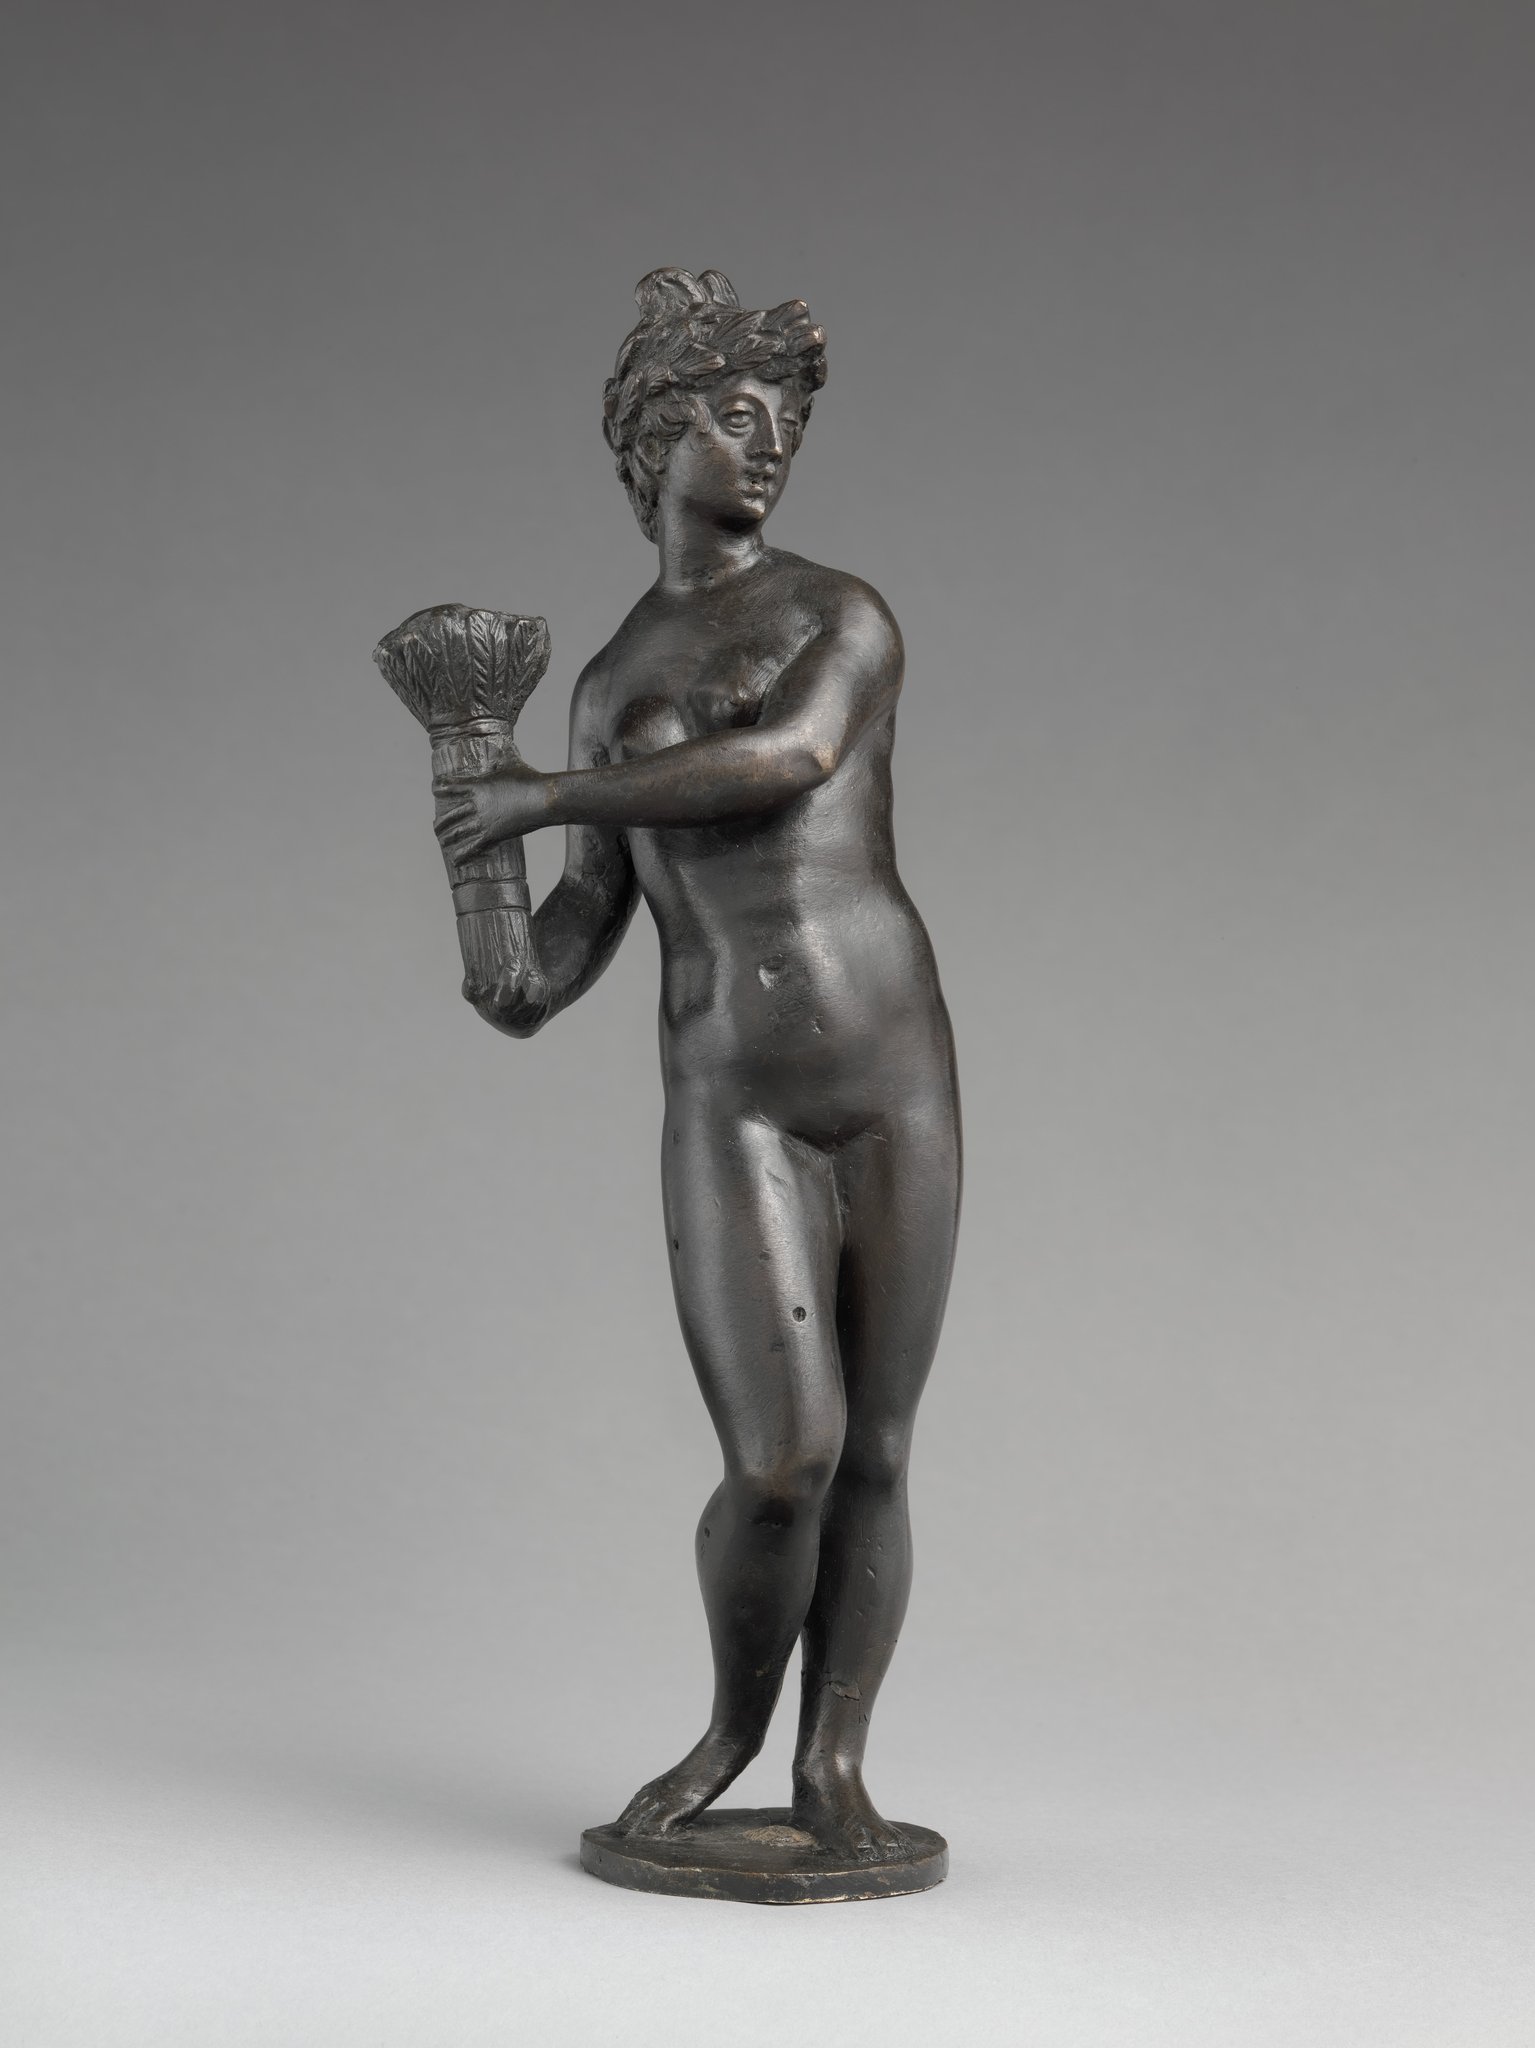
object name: statuette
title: Ceres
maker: niccolò roccatagliata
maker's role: artist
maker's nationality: italian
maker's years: 1593-1636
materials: bronze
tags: ceres